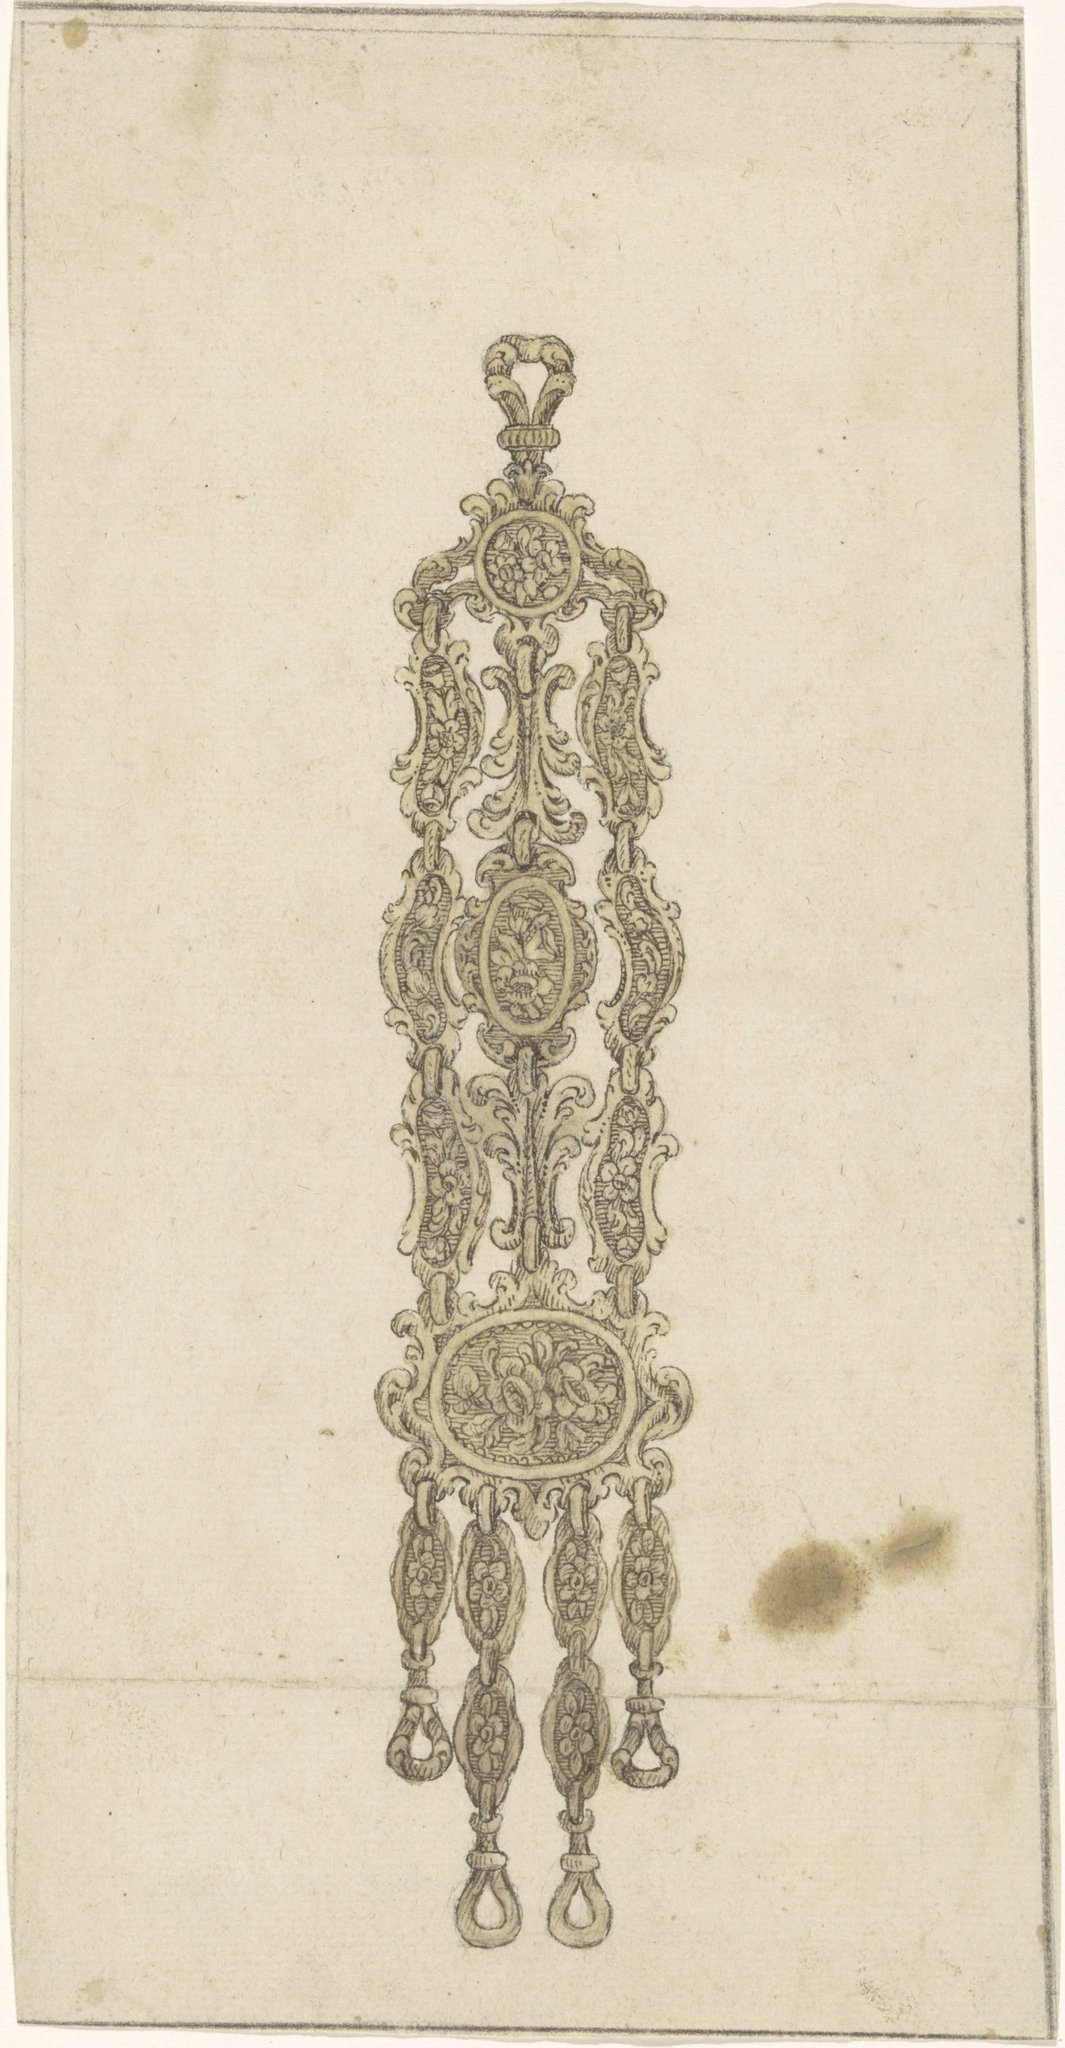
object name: design drawing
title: Ontwerp voor een chatelaine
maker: luigi valadier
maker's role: draughtsman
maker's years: 1726-1785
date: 1760-1780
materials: chalk, ink, paper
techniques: brush, pen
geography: rome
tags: watch